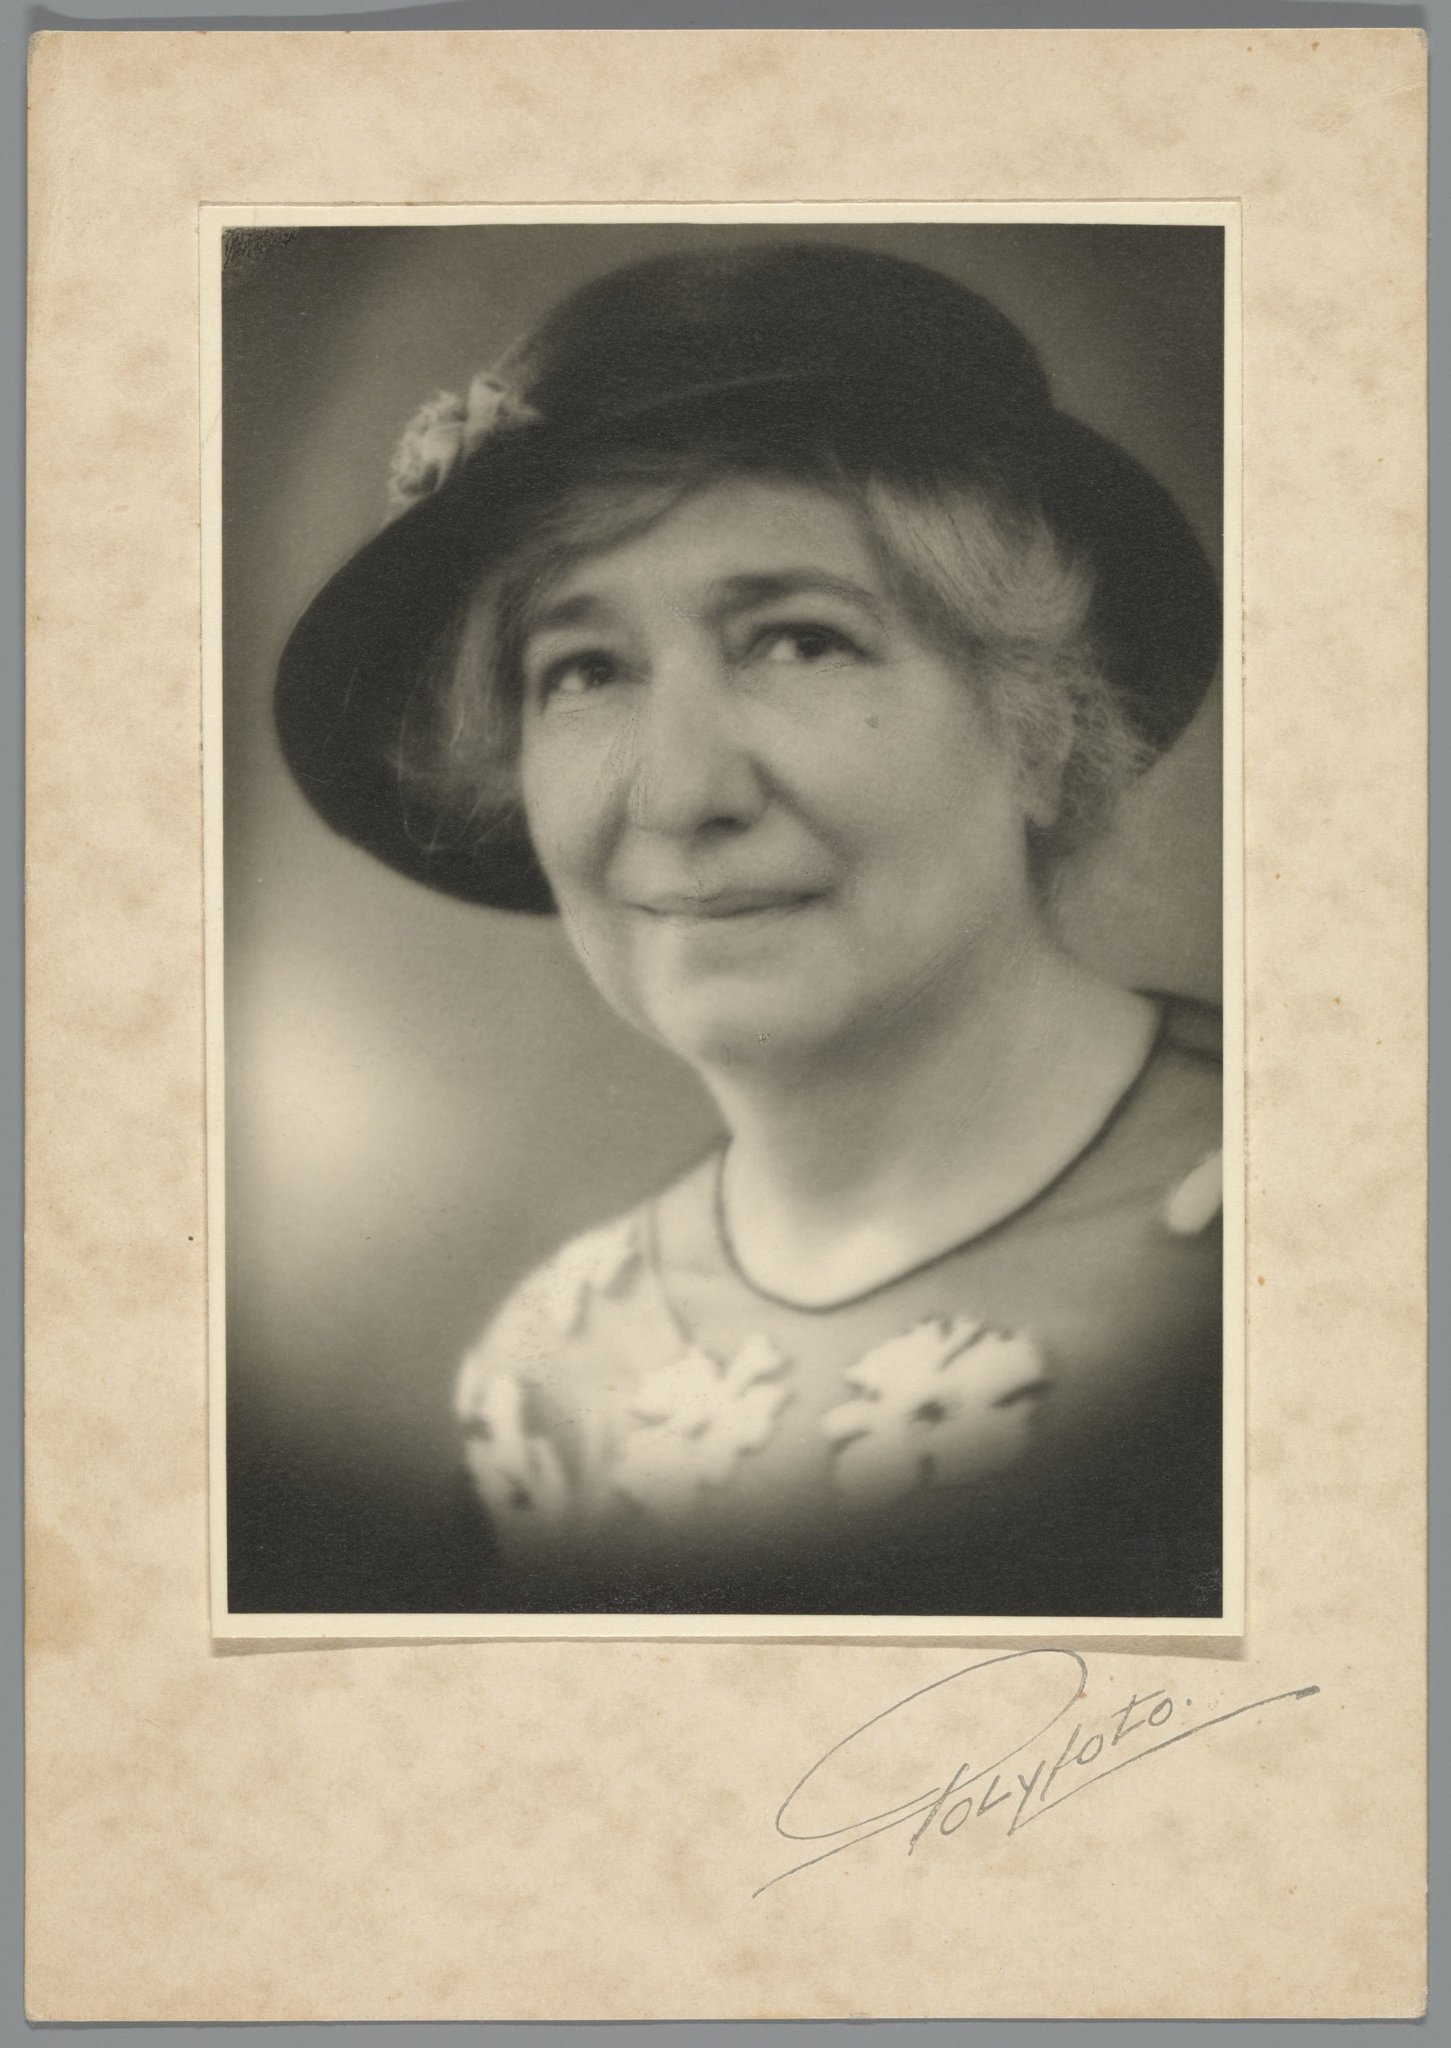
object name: photograph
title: Marie Witsen-Schorr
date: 1860-1915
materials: paper, photographic support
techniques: gelatin silver print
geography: netherlands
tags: augusta maria agnes witsen-schorr